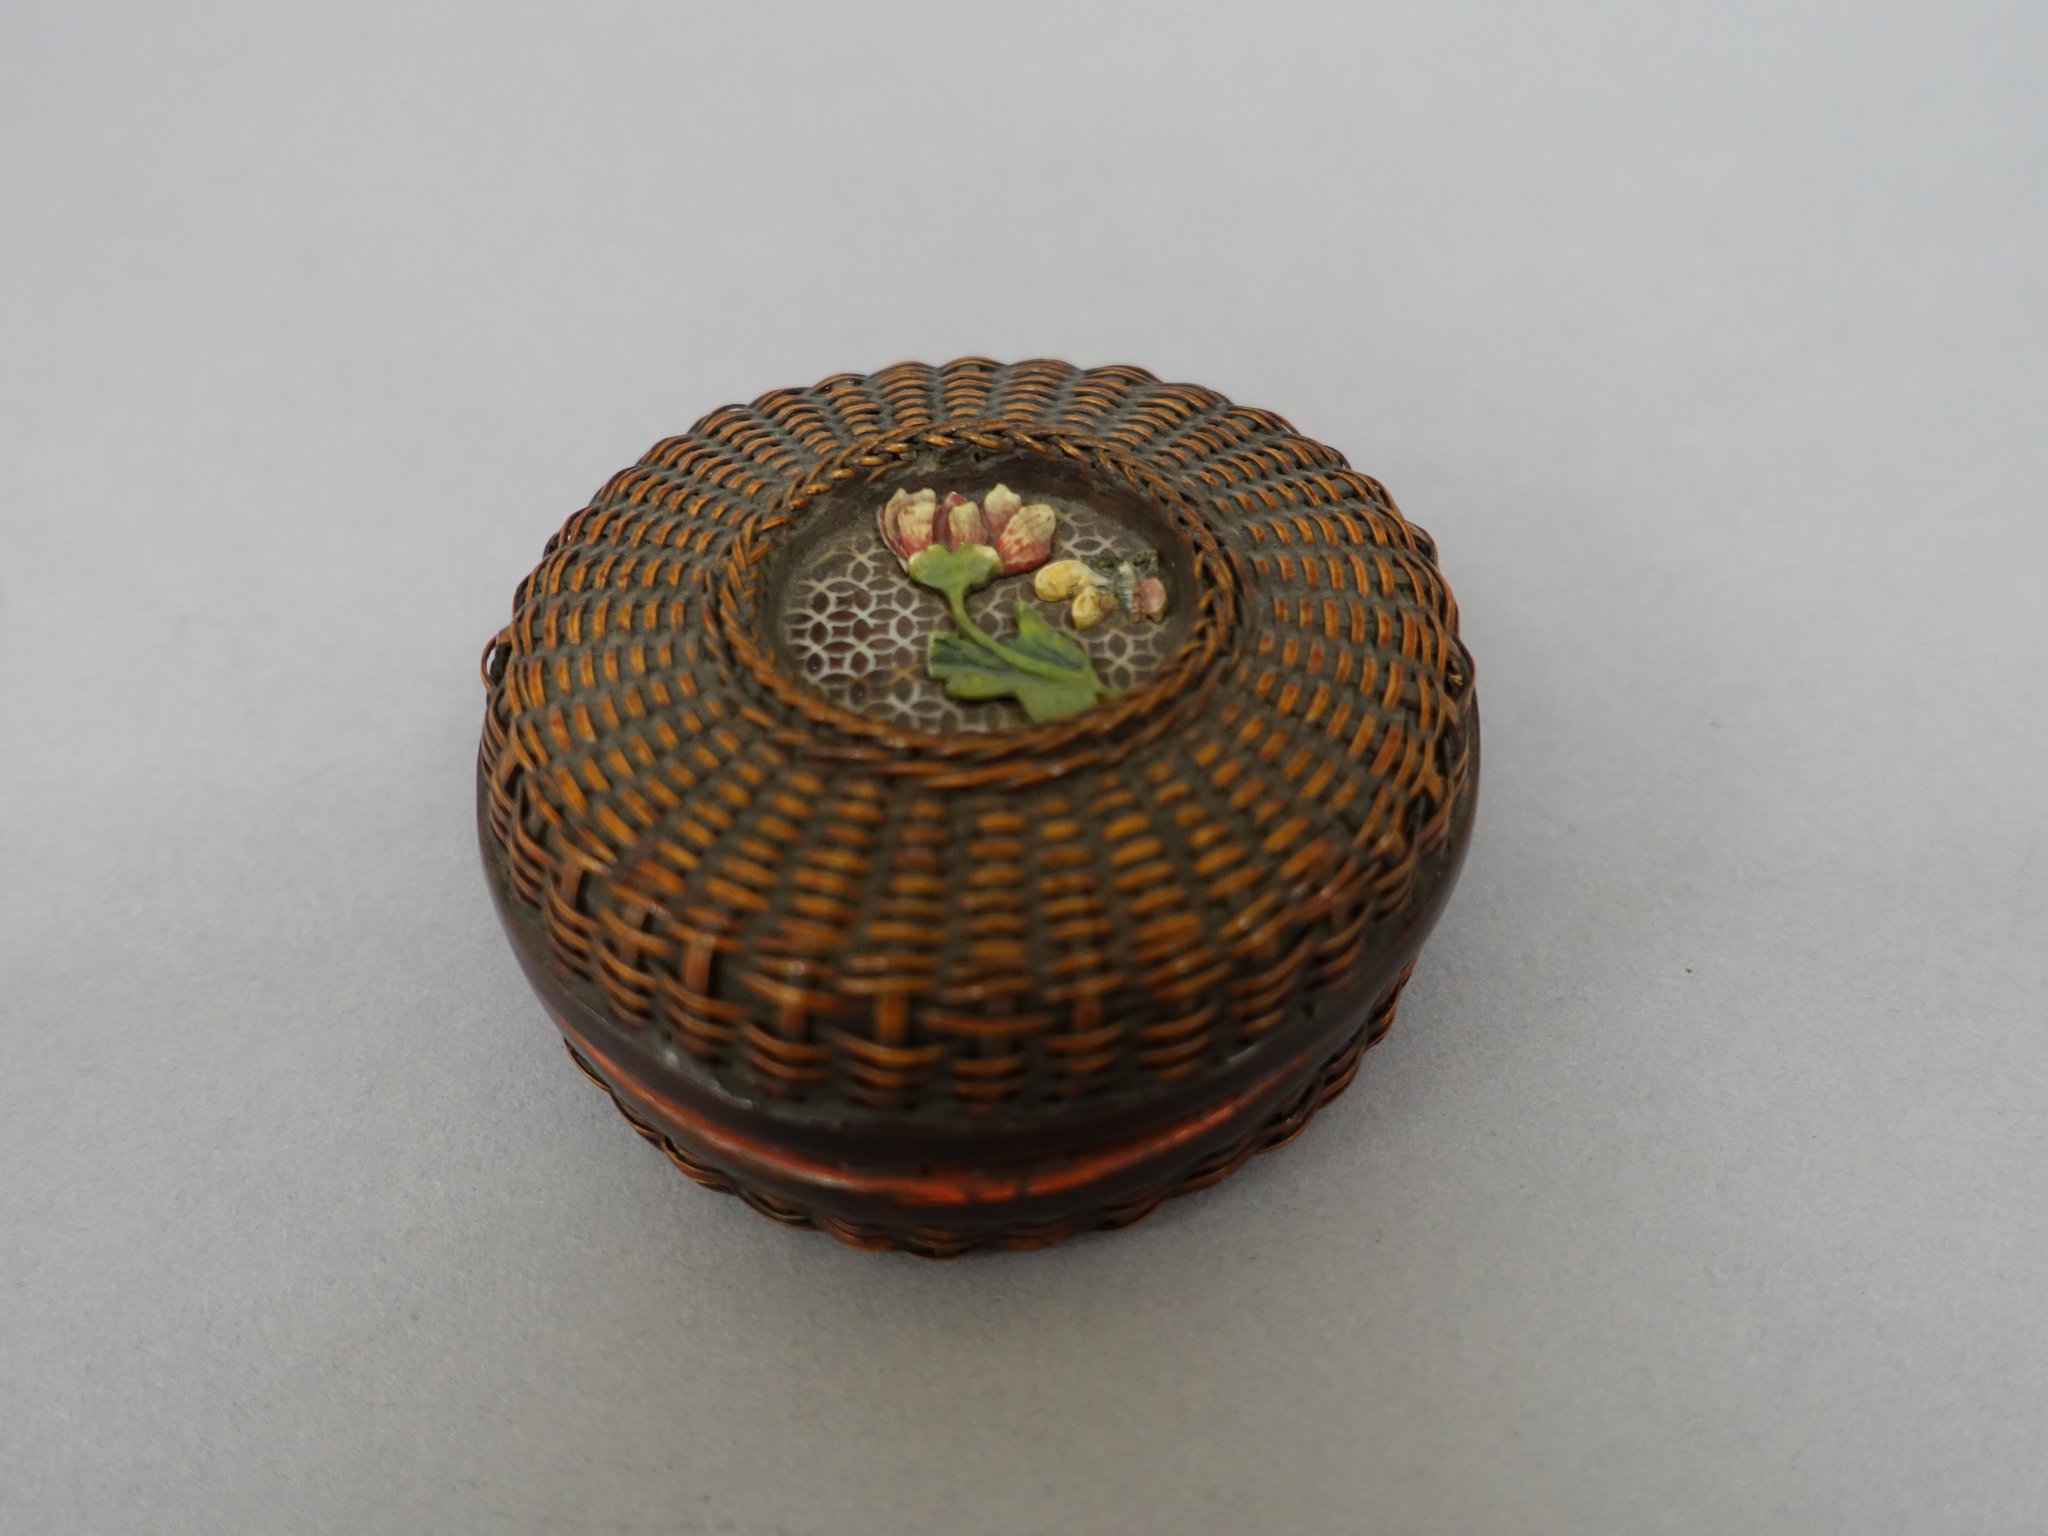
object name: covered box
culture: japanese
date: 1801-1900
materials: bamboo